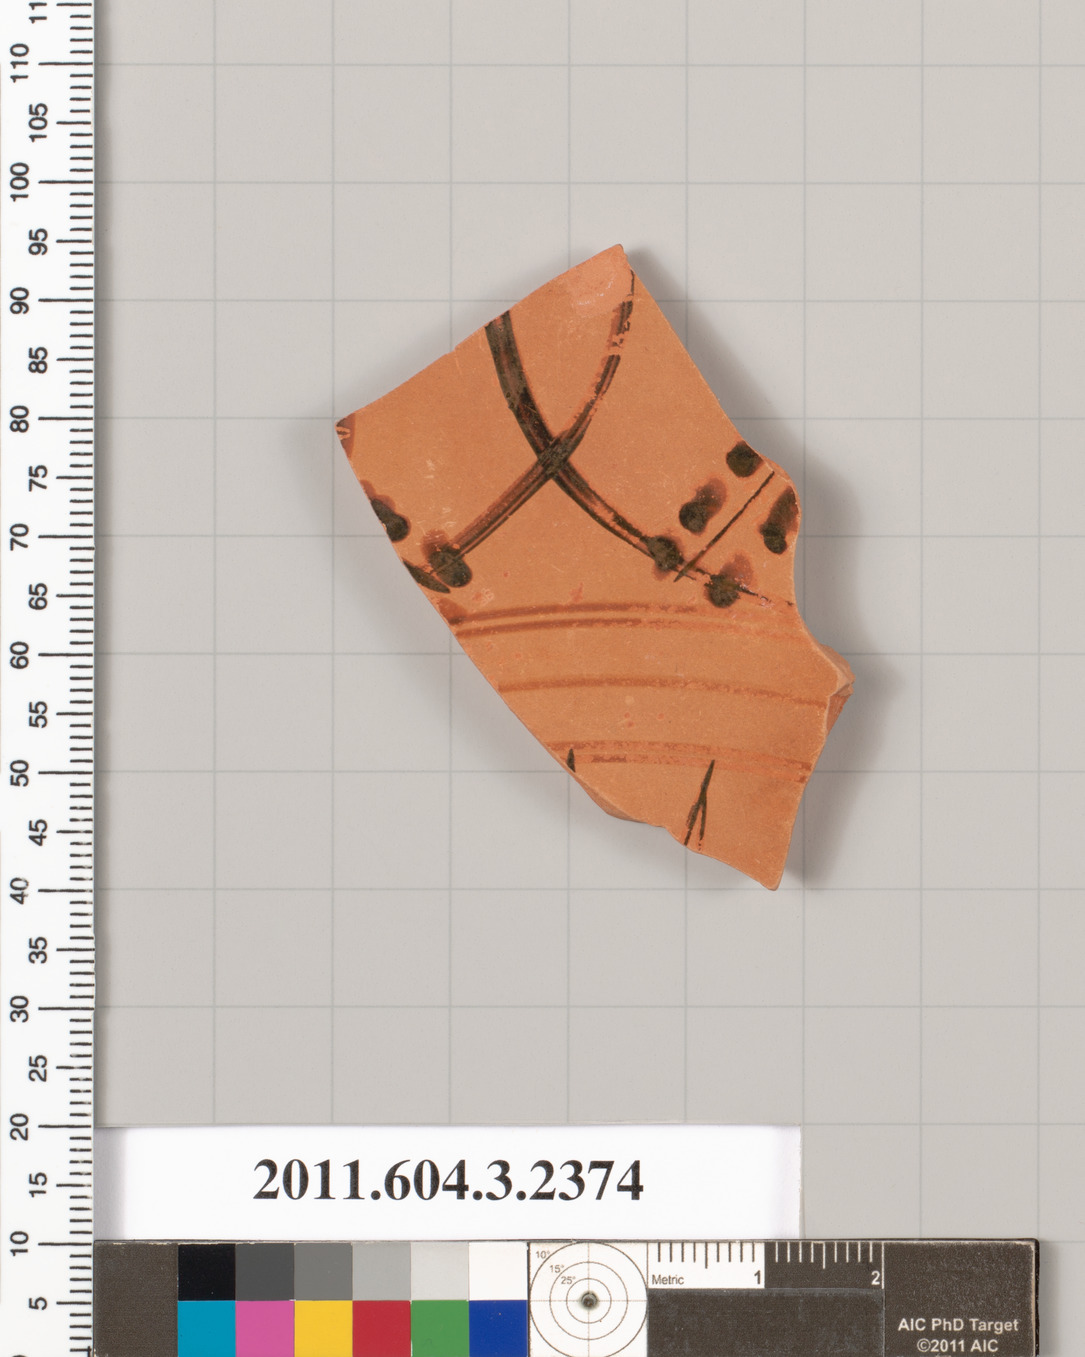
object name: kylix fragment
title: Terracotta fragment of a kylix: eye-cup (drinking cup)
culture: greek, attic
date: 540-520 BCE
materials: terracotta